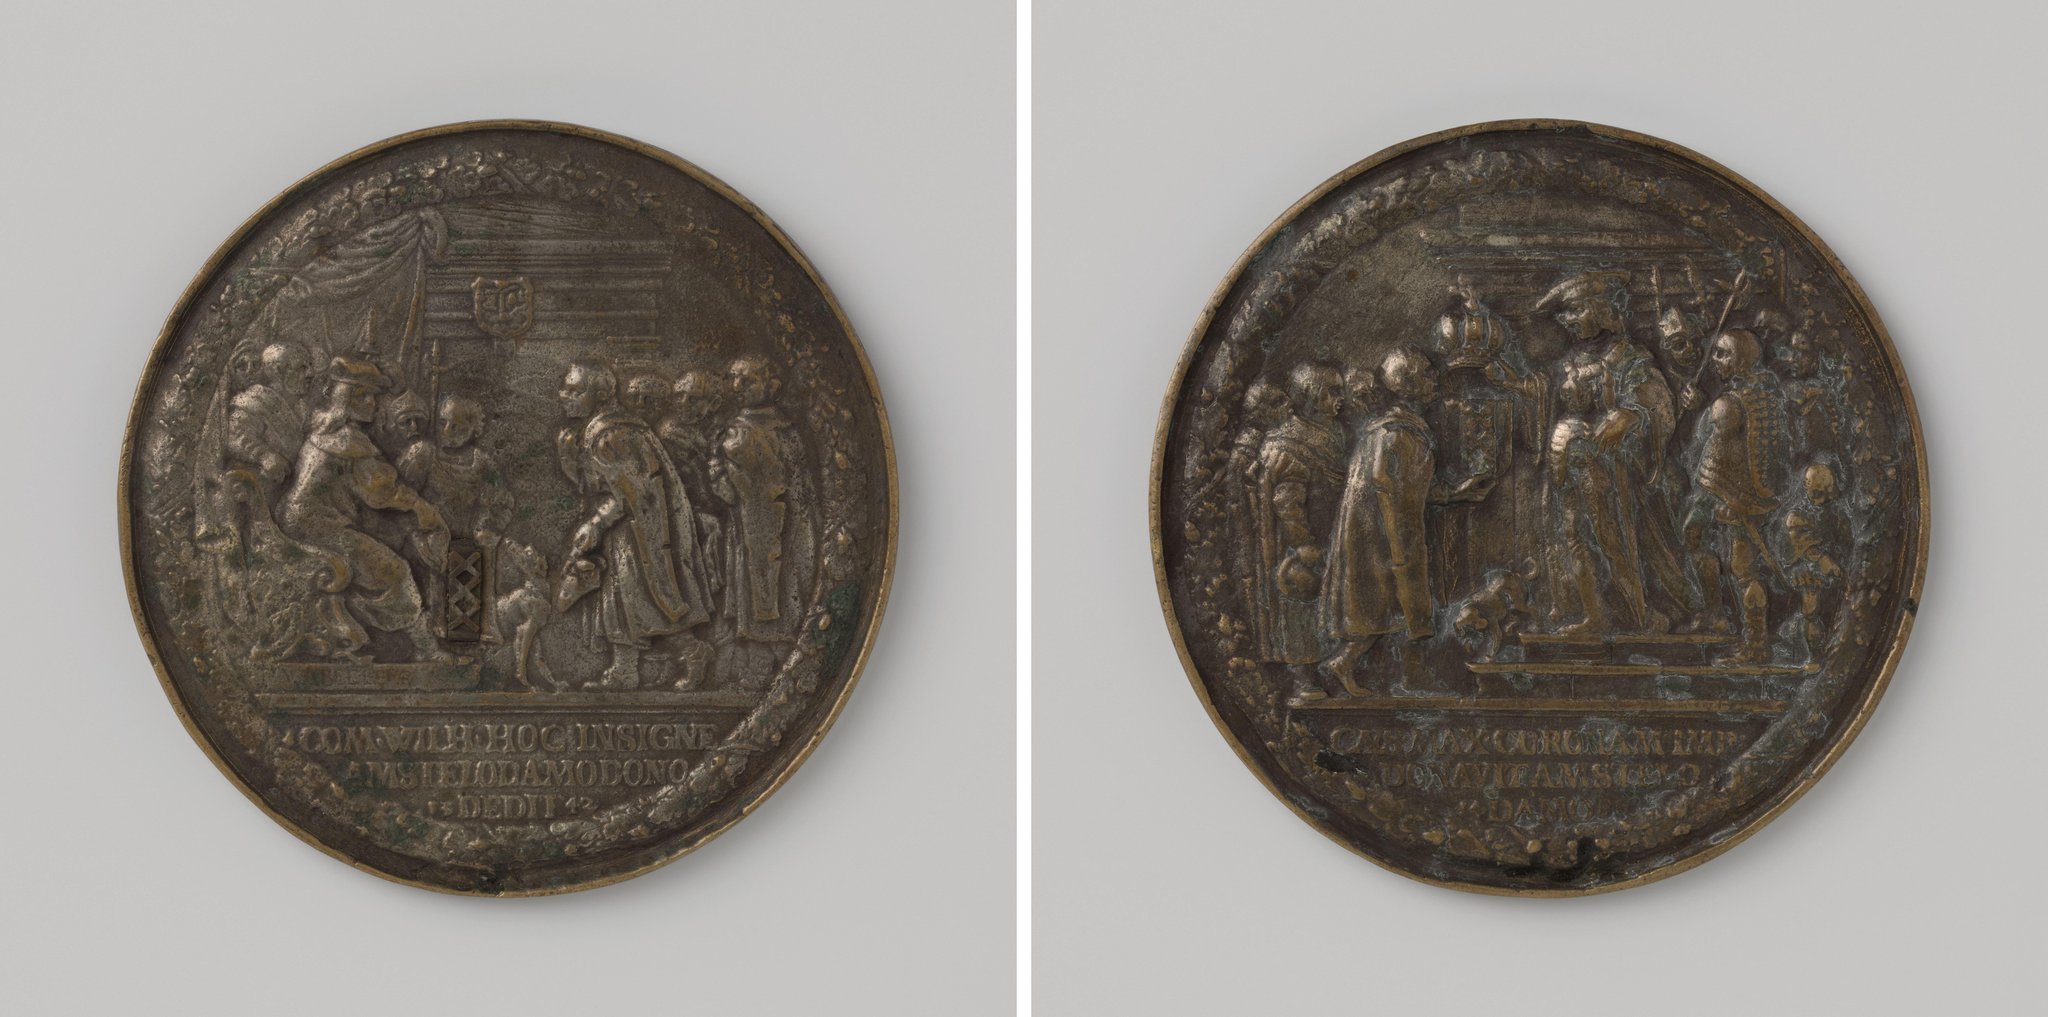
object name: history medal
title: Honderdjarige herdenking van de verlening van het recht een keizerskroon boven het wapen te dragen door Keizer Maximiliaan aan Amsterdam 1578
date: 1578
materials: brass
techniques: casting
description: Grote messing penning, op de voorzijde binnen een krans de getroonde Graaf Willem die het Hollandse wapenschild ontvangt, met opschrift in de afsnede, op de keerzijde binnen een krans Maximiliaan die een keizerskroon boven het wapen houdt, met opschrift in de afsnede